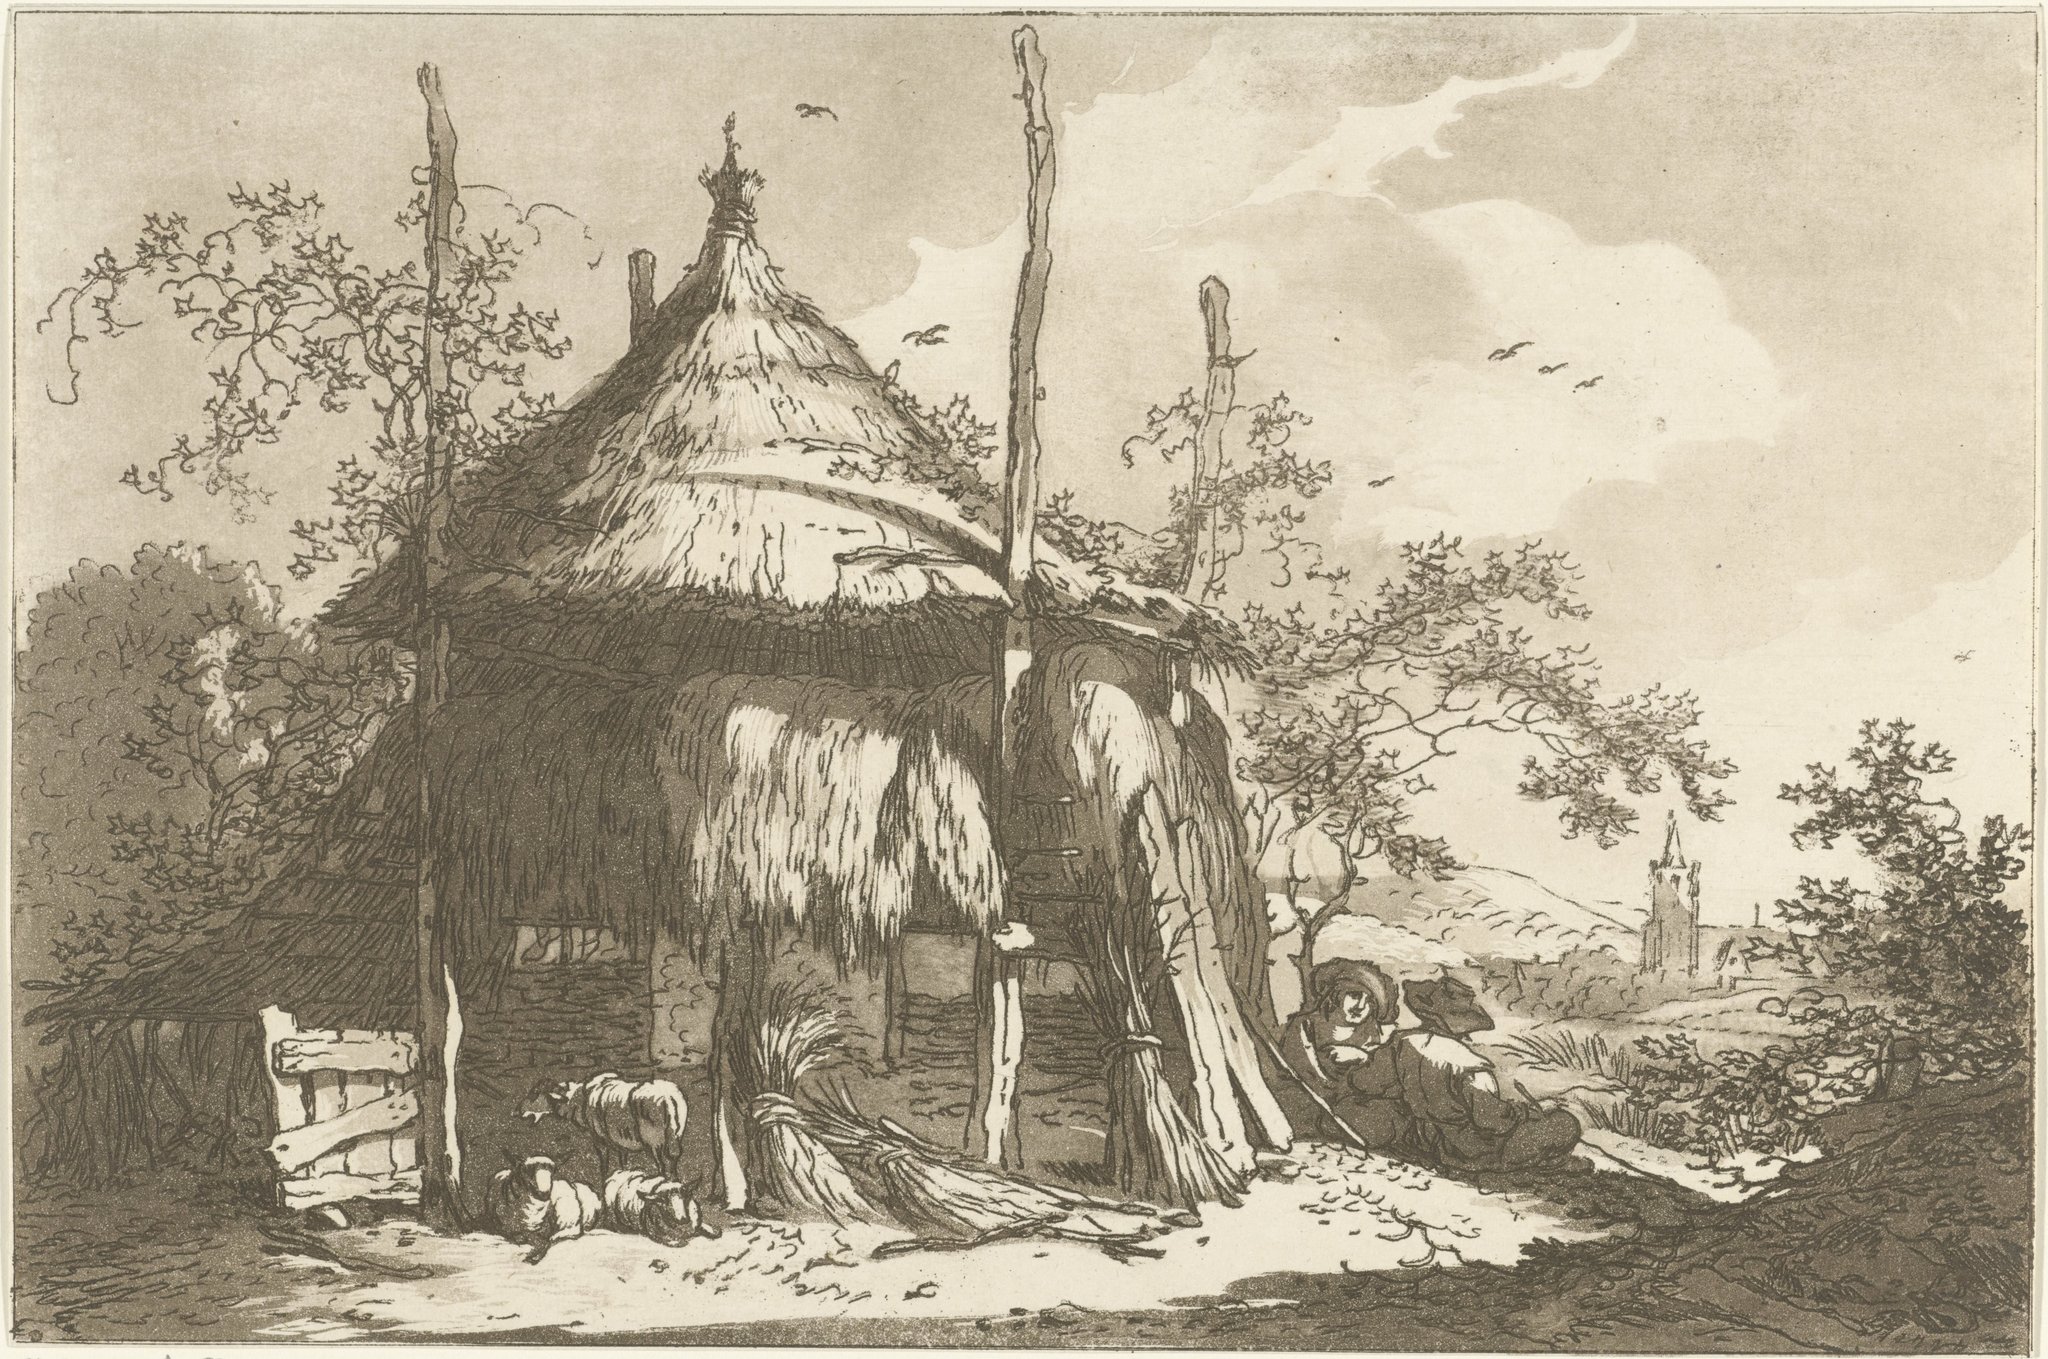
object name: print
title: Herders bij een hooiberg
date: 1789-1793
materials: paper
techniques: aquatint, etching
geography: london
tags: herding, herdsman, herdswoman, shepherd, shepherdess, cowherd, etc., sheep, hay-stack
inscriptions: collector's mark: Lugt 2228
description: Twee zittende herders bij een deels lege hooiberg. Bij het hek drie schapen. Op de achtergrond een torenspits.